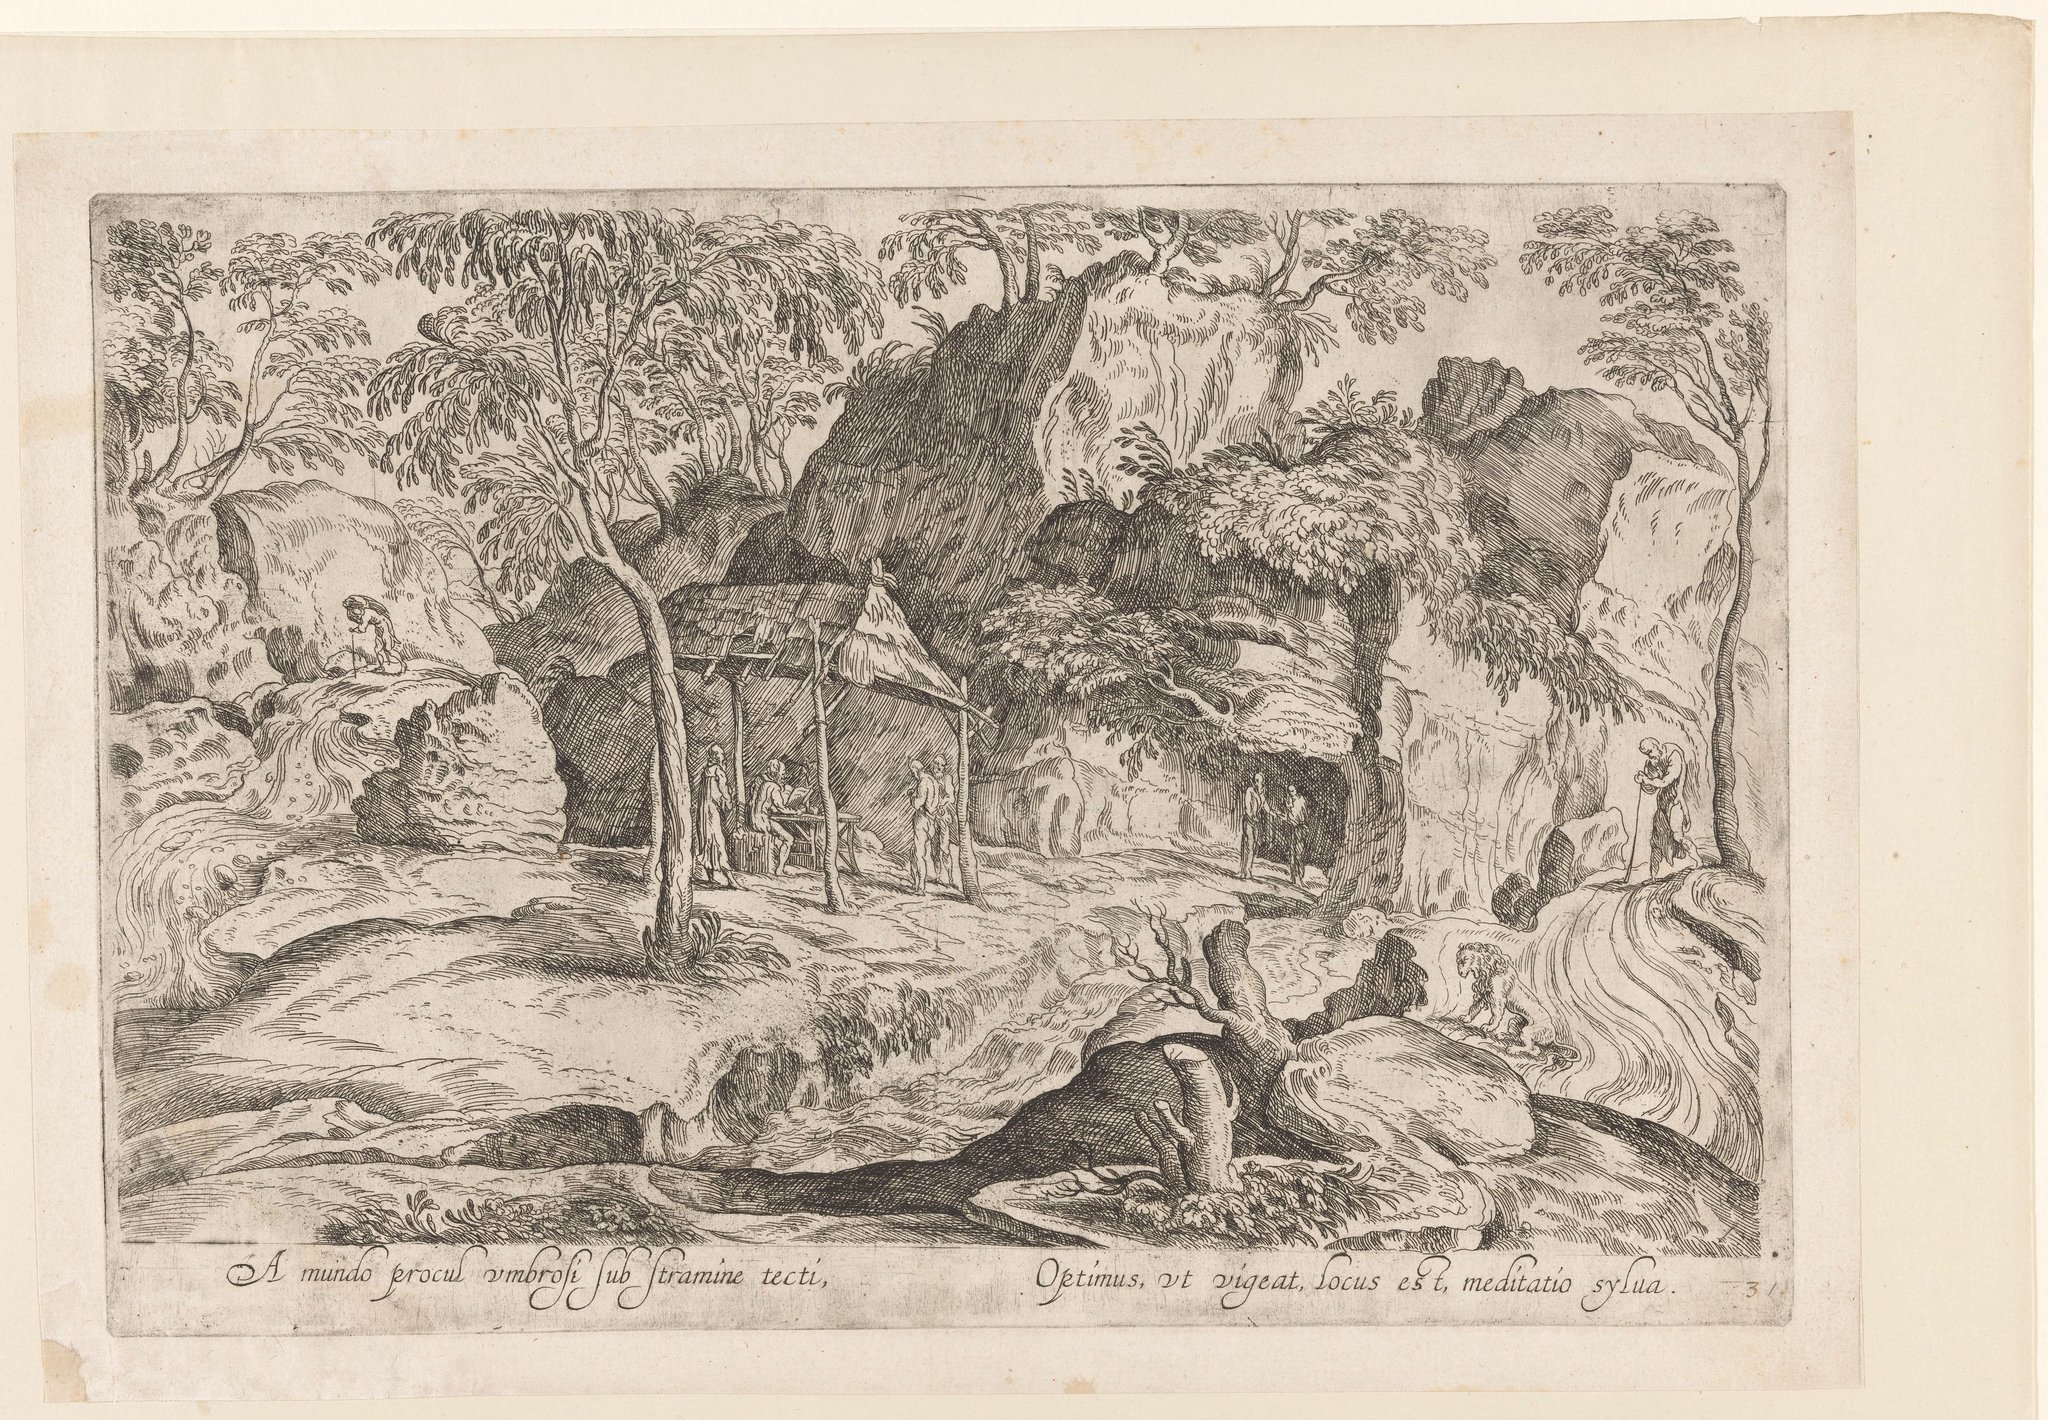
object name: print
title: Rotsachtig landschap met dak op palen en rechts leeuw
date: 1600-1699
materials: paper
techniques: etching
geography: italy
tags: landscapes, beasts of prey, predatory animals: lion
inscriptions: collector's mark: Lugt 2228, number: ‘3’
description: Rotsachtig landschap met centraal een dak op palen, waaronder mannen bidden voor een crucifix. Rechts een brullende leeuw. Titel in het Latijn in ondermarge.